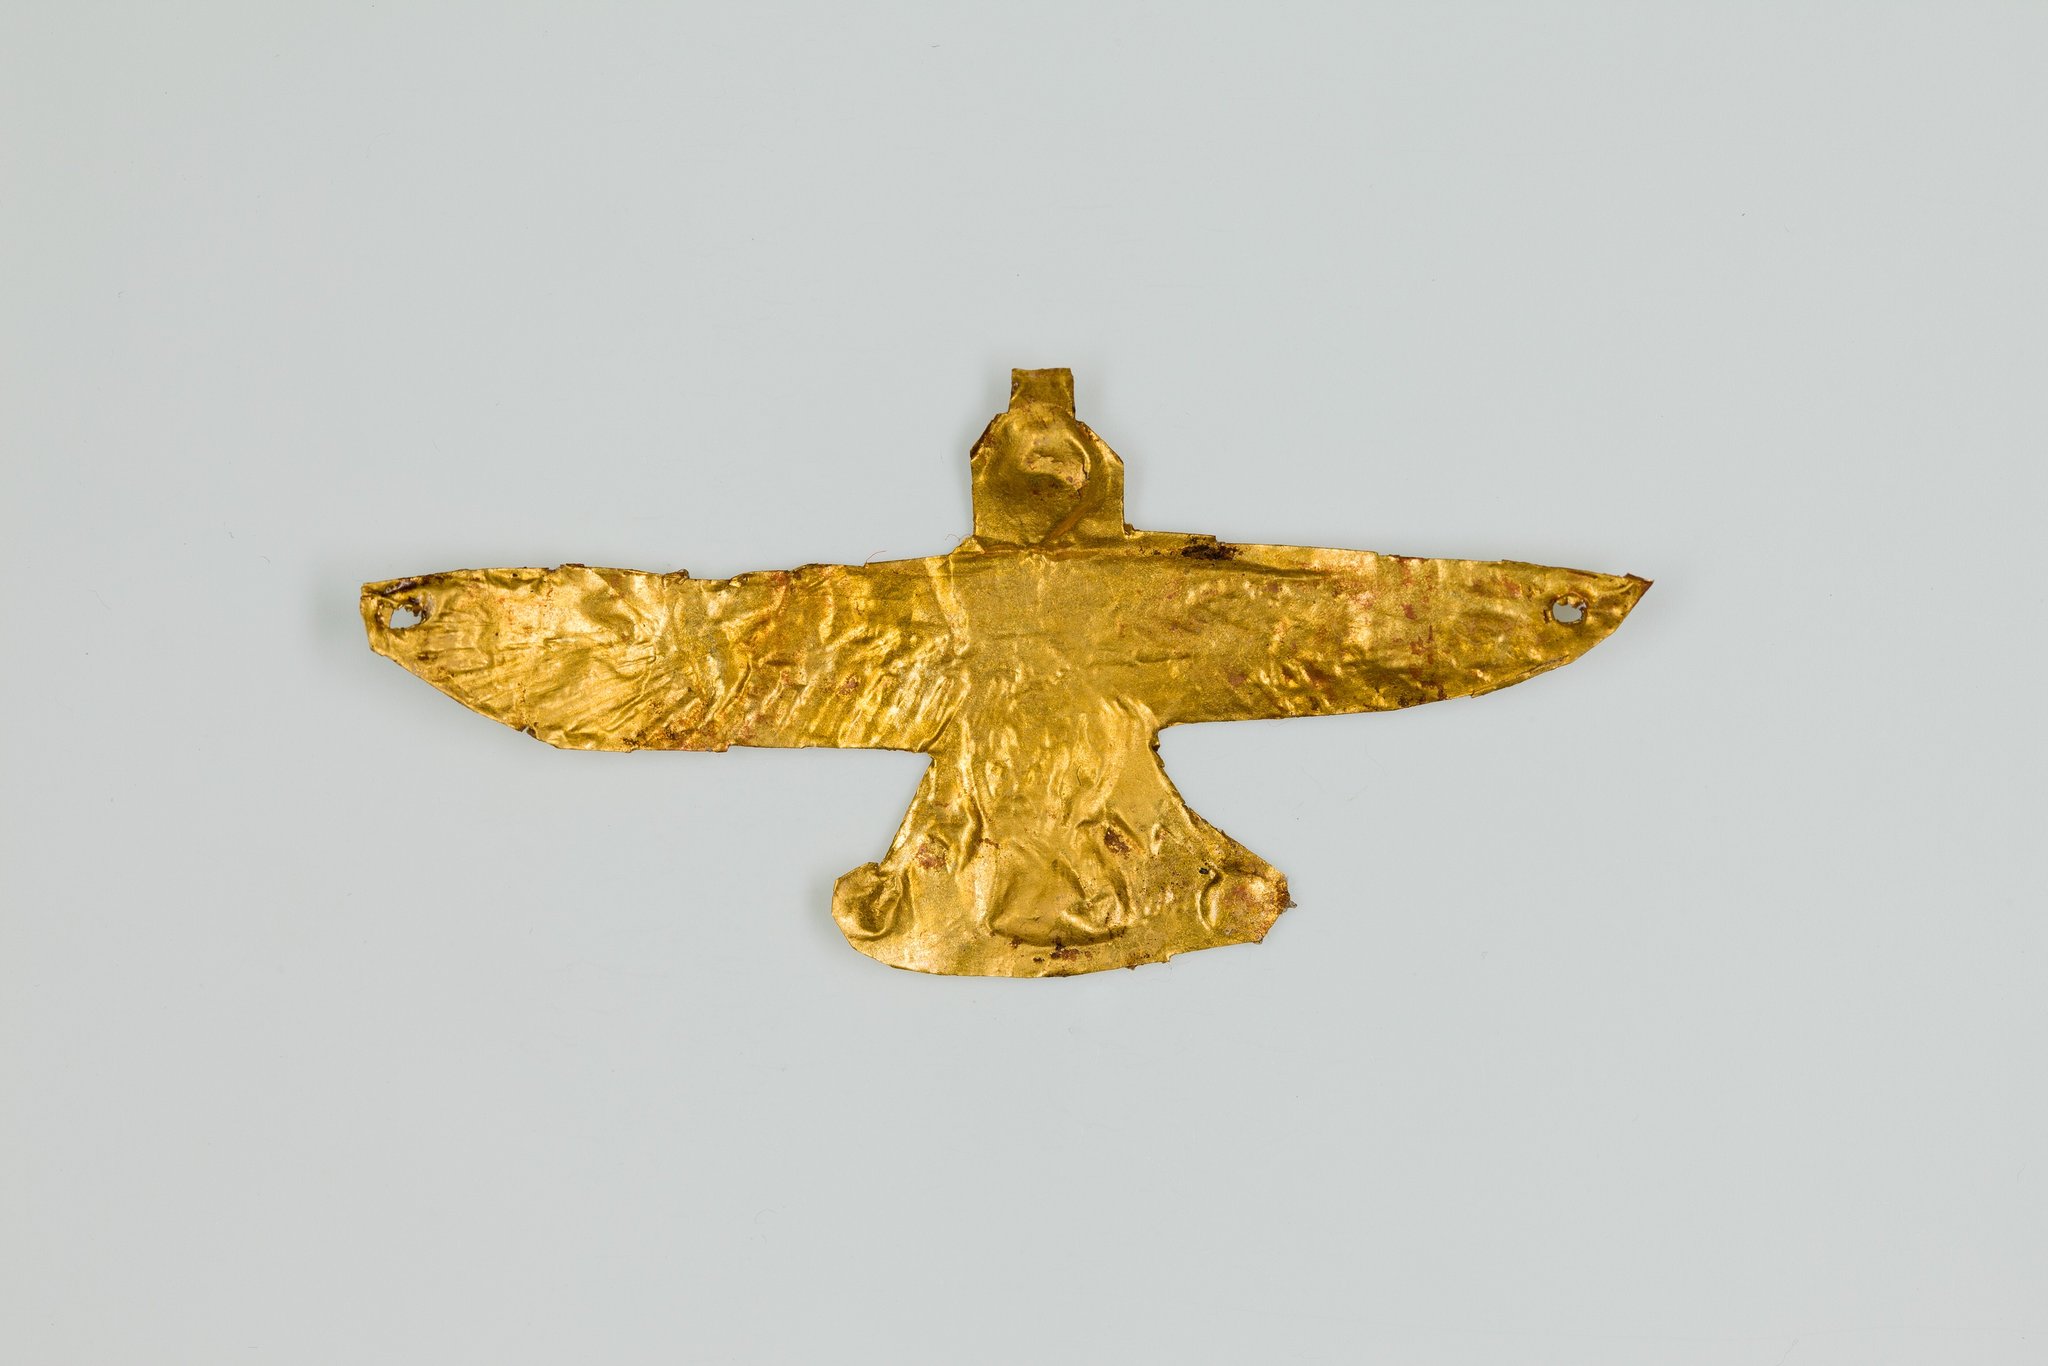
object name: amulet, ba bird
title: Ba-bird amulet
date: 664-380 BCE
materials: gold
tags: birds